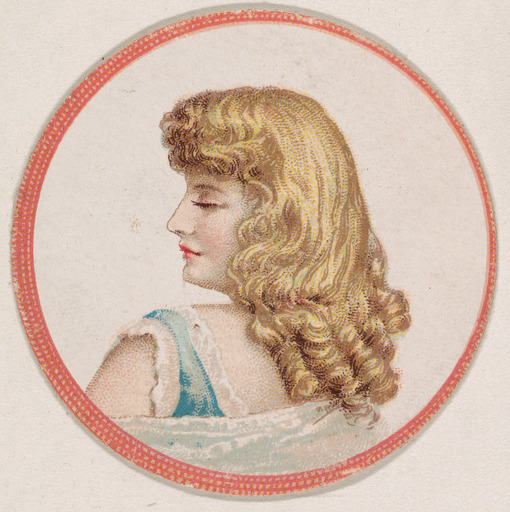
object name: print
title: Portrait of woman, from the Novelties series (N228, Type 2) issued by Kinney Bros.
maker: kinney brothers tobacco company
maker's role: publisher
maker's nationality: american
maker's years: 1869-2011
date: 1889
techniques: color lithograph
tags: profiles,women